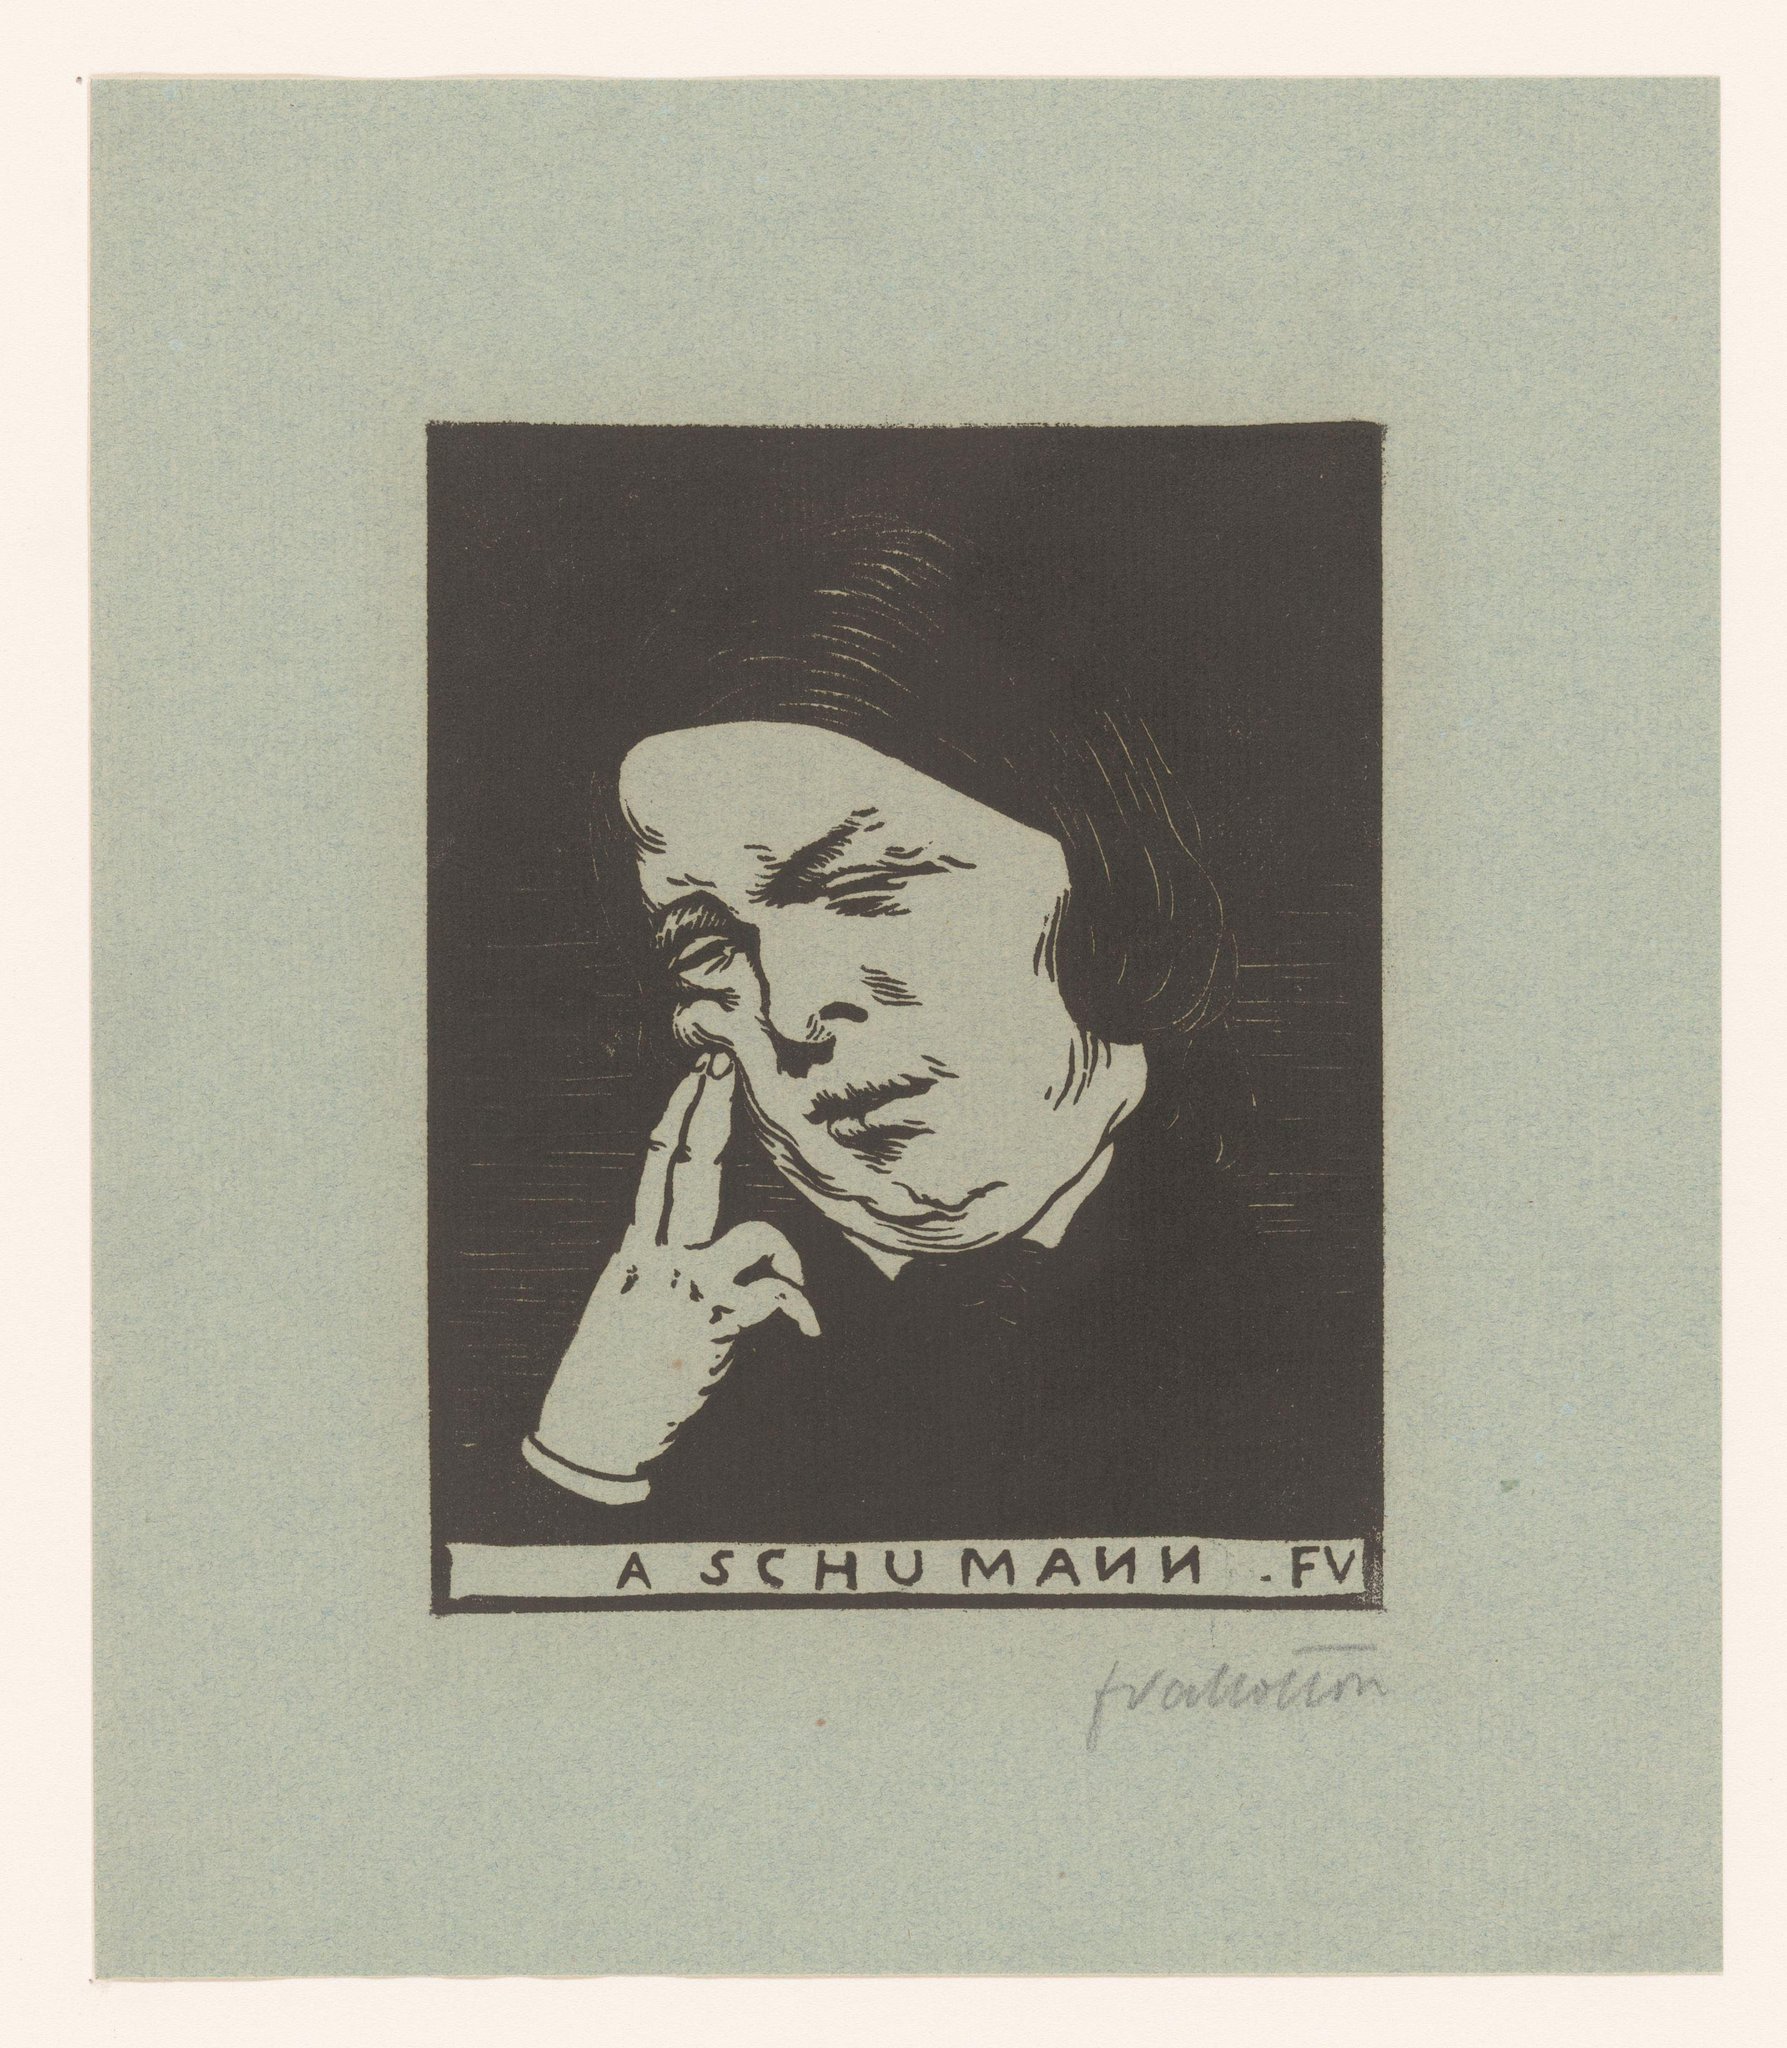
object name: print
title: A Schumann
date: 1895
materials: paper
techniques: woodcut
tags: zwickau, robert schumann, historical persons, portrait of composer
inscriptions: collector's mark: Lugt 2228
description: Prent uit: Pan 1, april-mei 1895, p. 24.